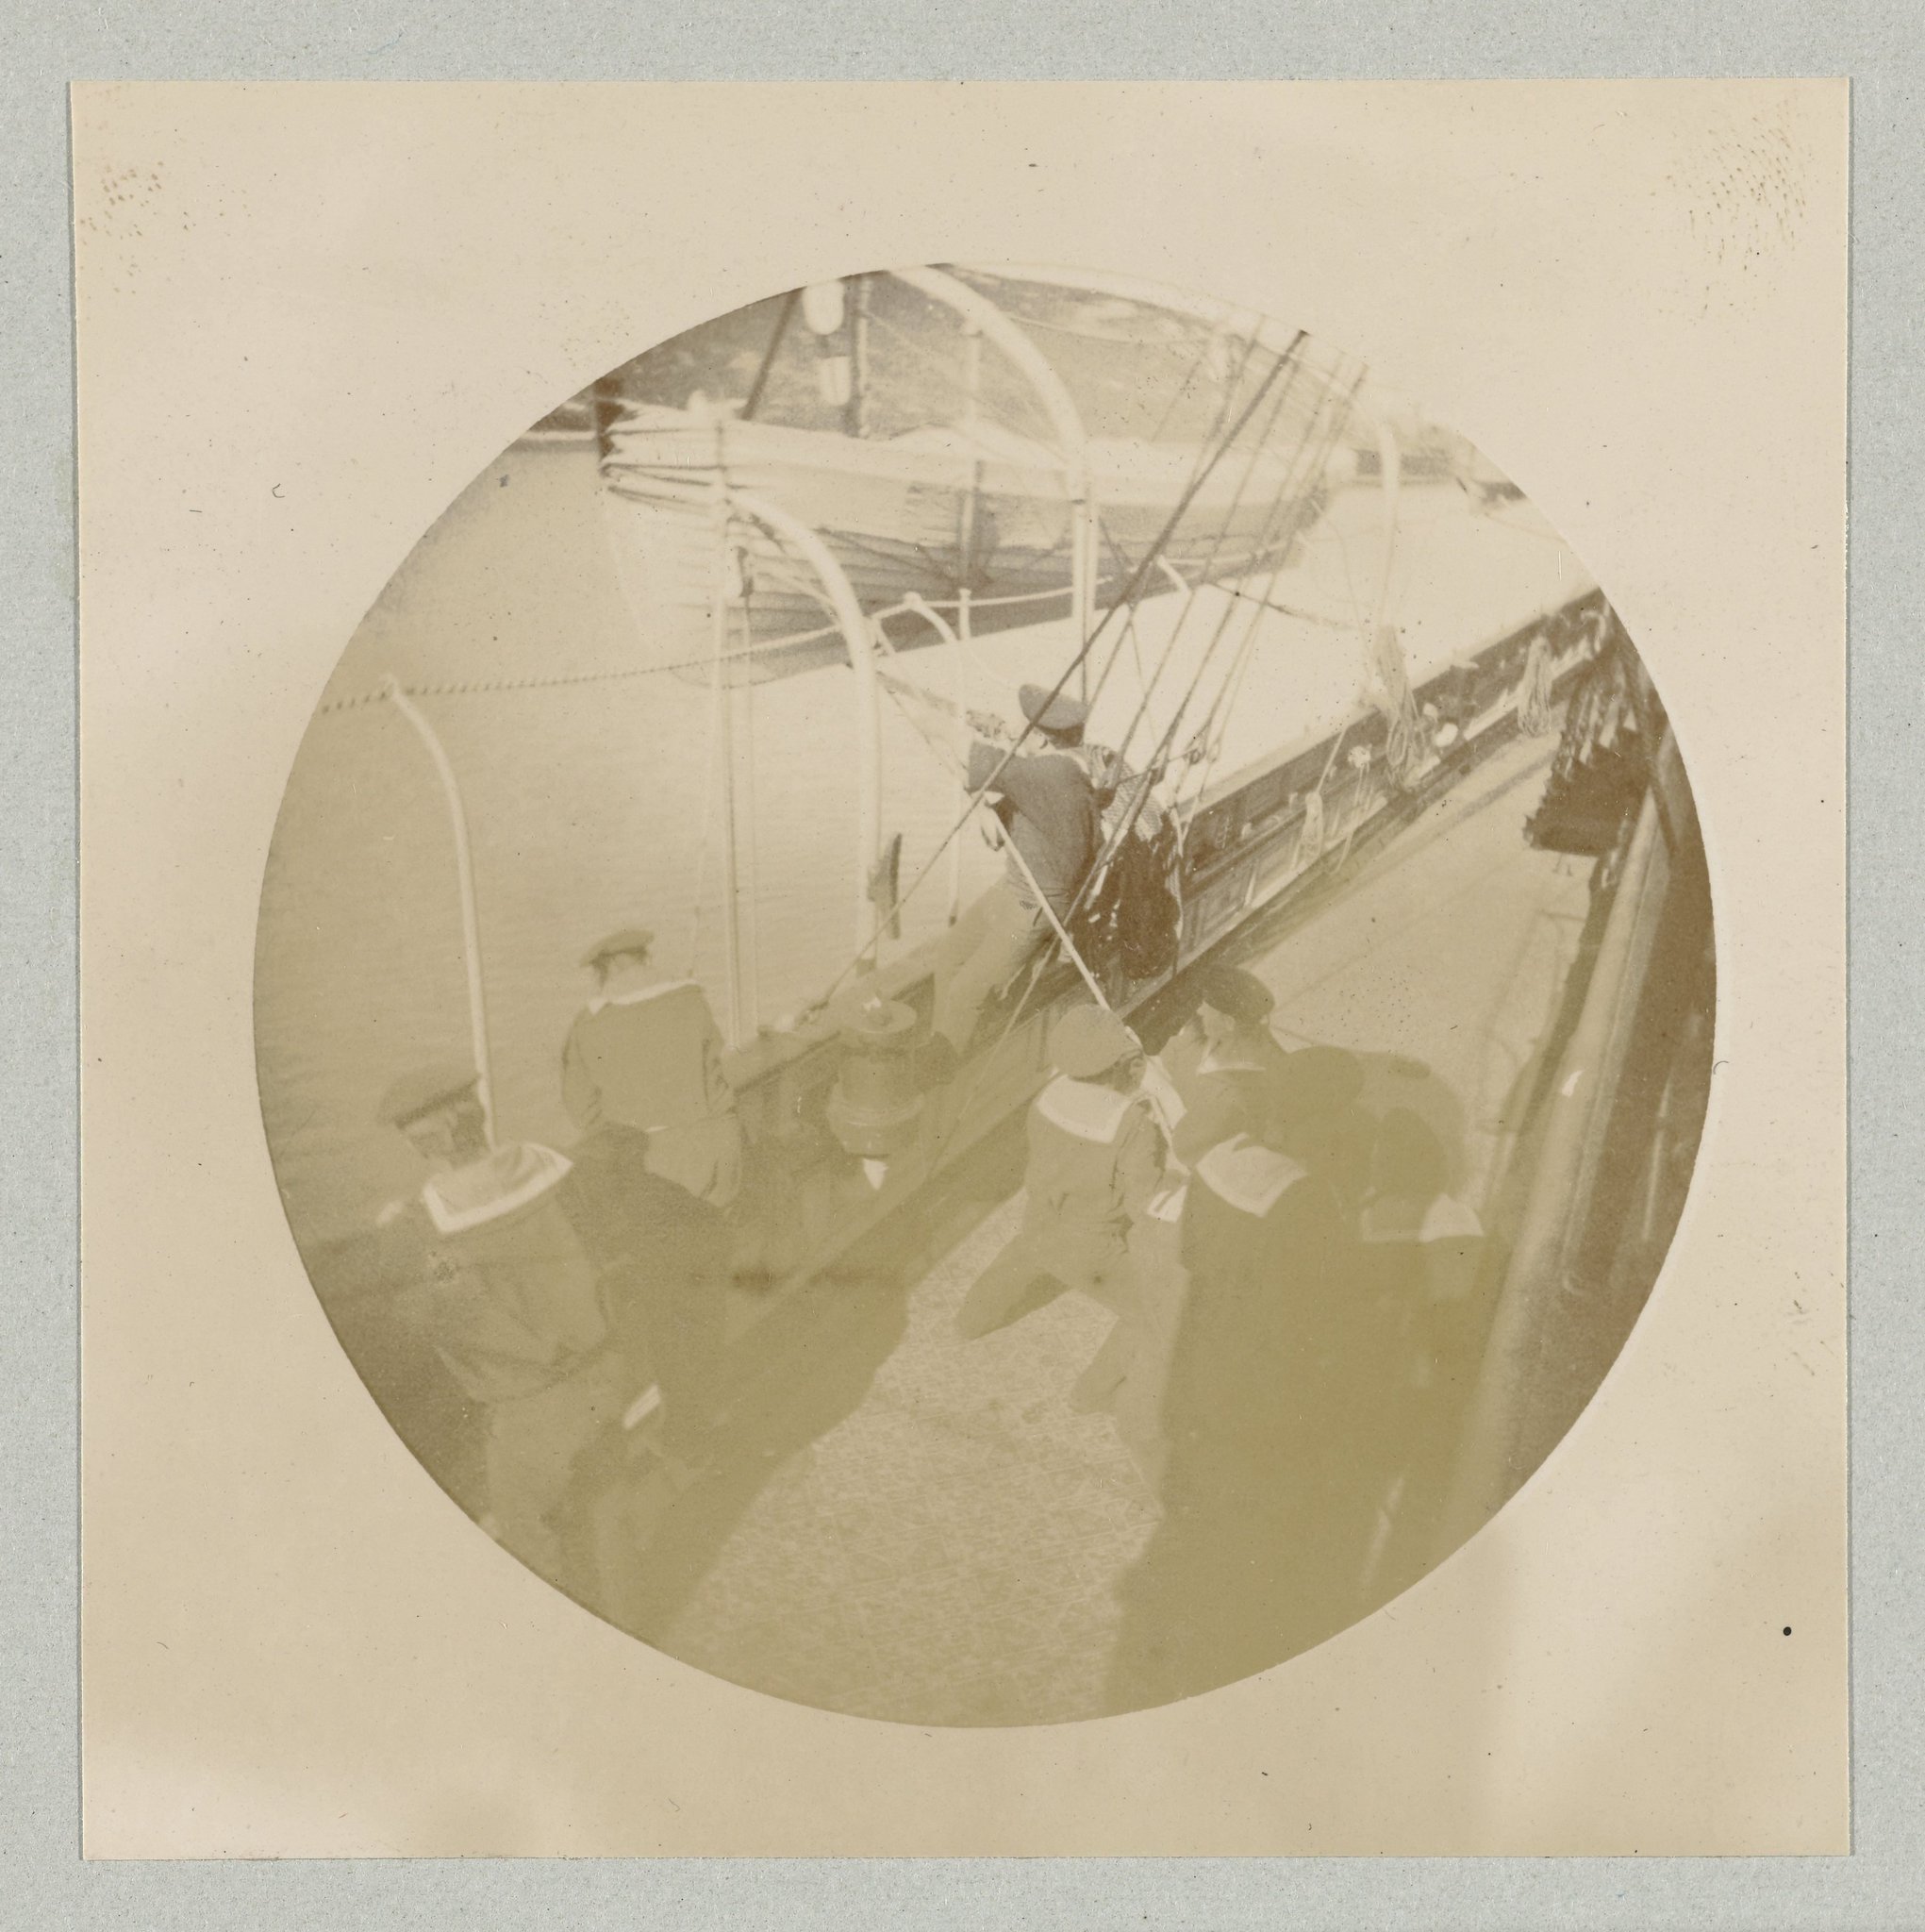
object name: photograph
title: Matrozen staan aan de railing van een schip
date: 1807-1889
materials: cardboard, paper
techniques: gelatin silver print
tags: wilhelm ii (keizer van duitsland), norway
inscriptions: number: ‘12’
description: De afdruk van de foto is rond, het papier vierkant. foto gemaakt met Nr. 1 Kodak Camera